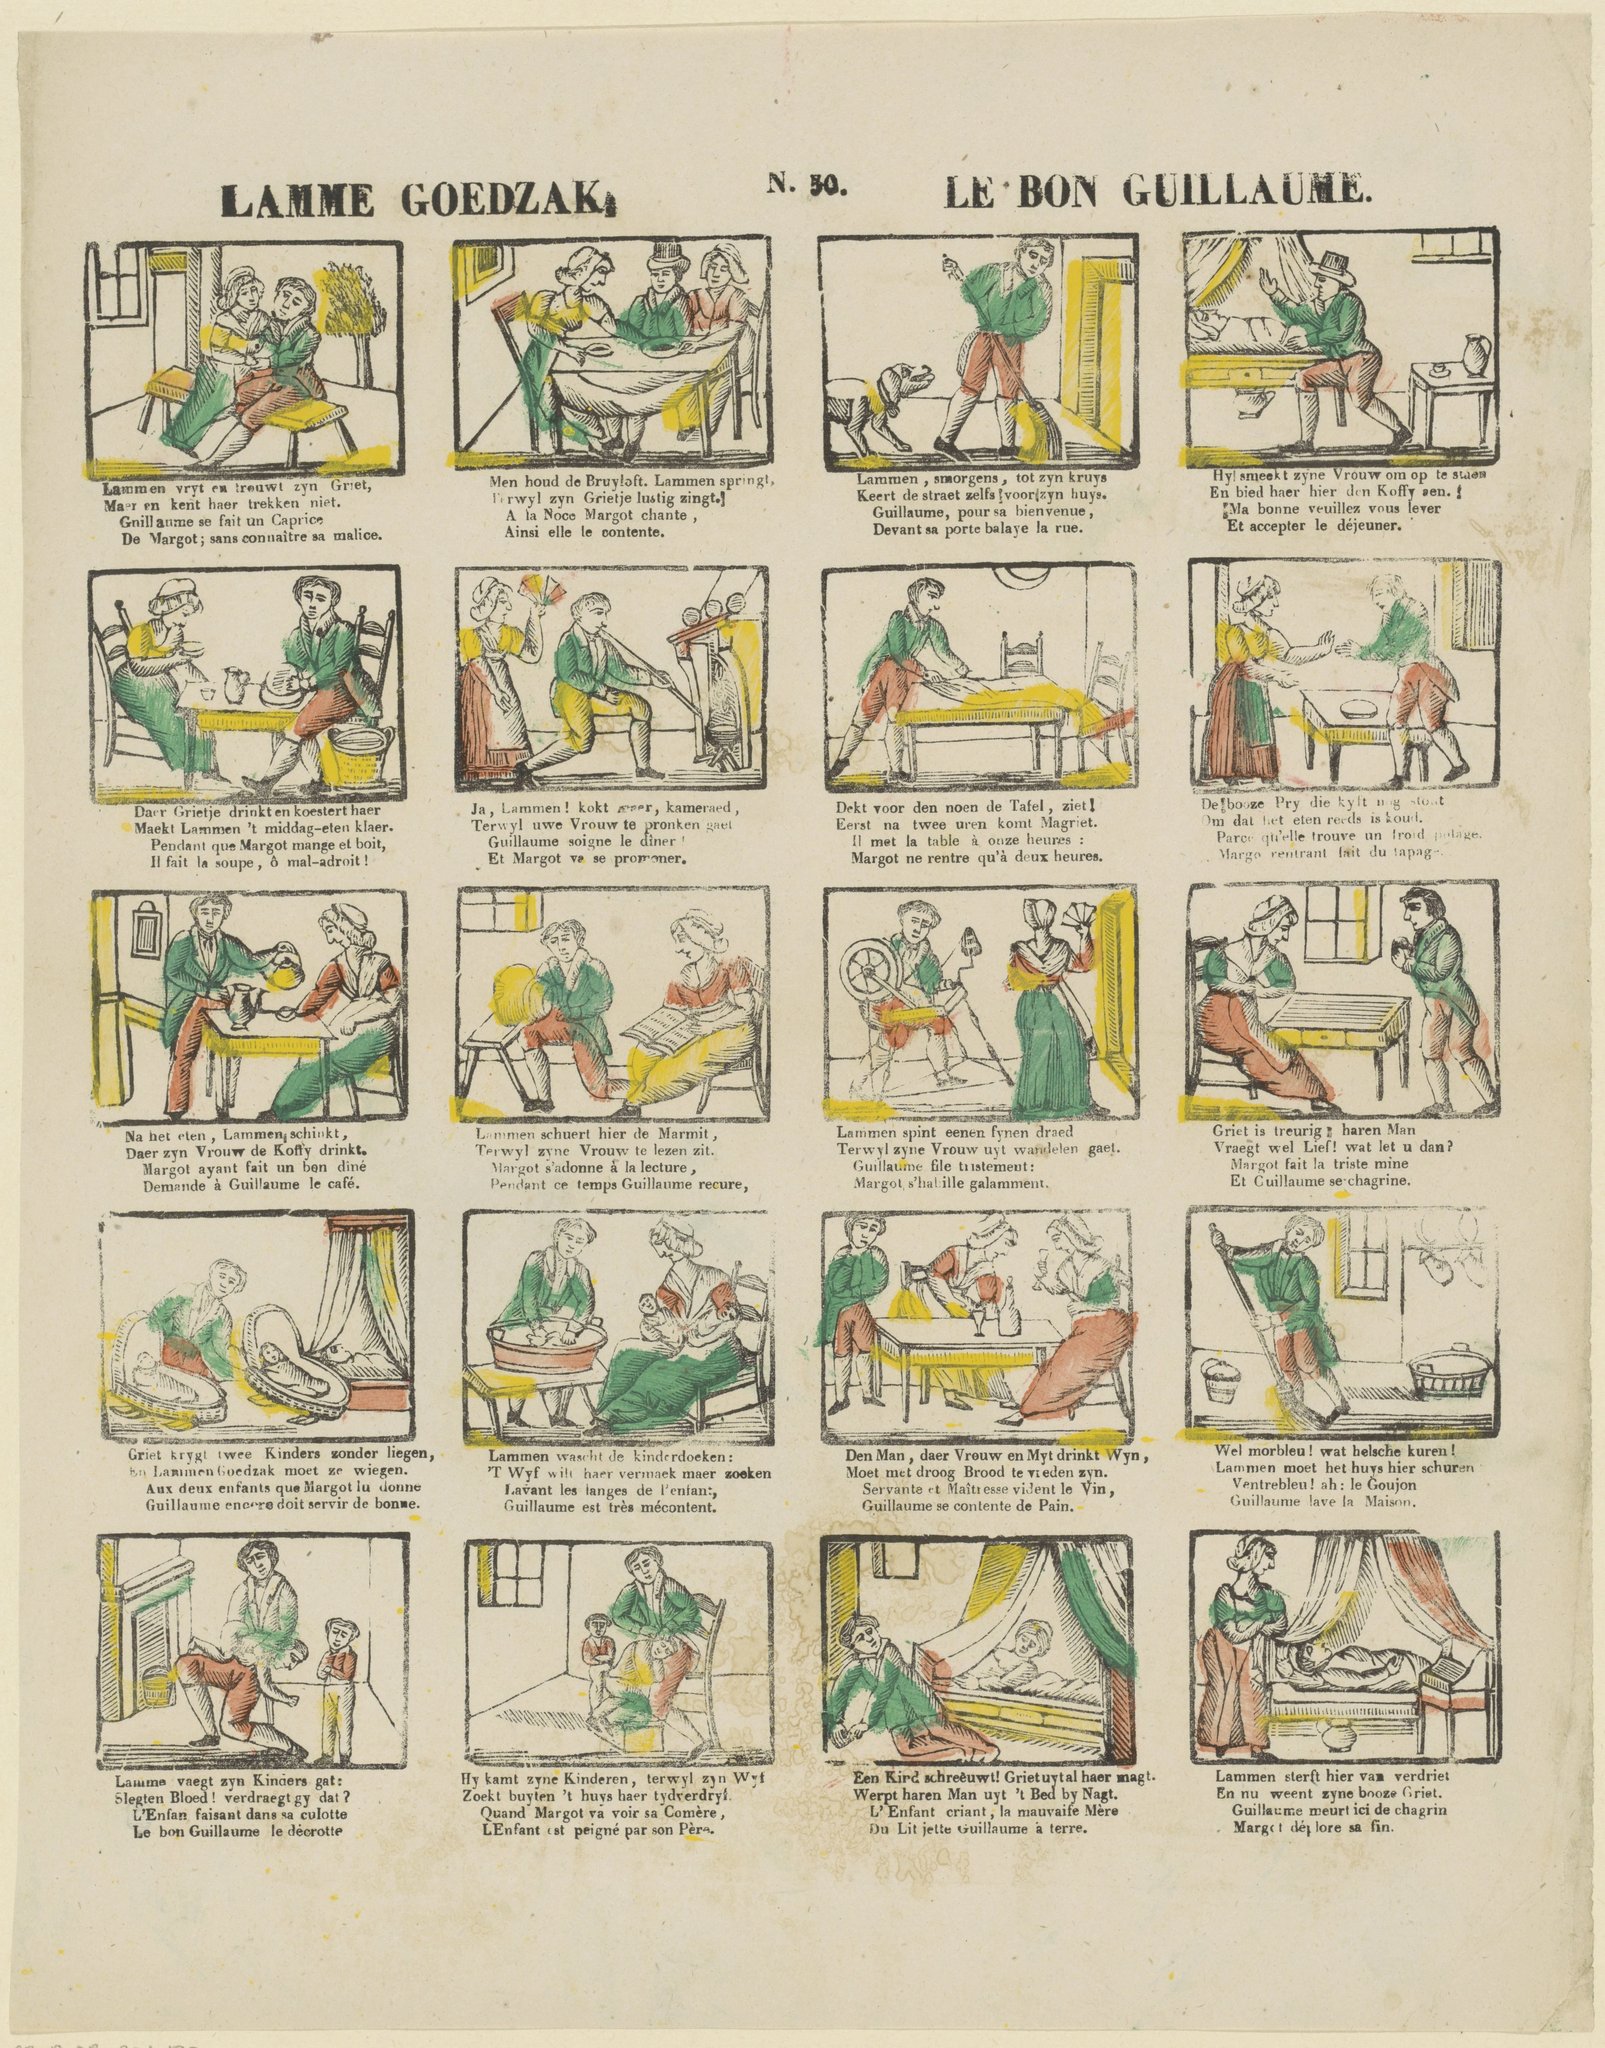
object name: print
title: Lamme goedzak / Le bon Guillaume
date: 1866-1902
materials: paper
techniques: colour, letterpress printing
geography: europe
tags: hen-pecked husband, 'betty', 'molly' (man who engages in women's work)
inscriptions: collector's mark: Lugt 2760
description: Blad met 20 voorstellingen over het leven en de bezigheden van Lamme Goedzak en zijn Griet. Onder elke voorstelling een tweeregelig vers in het Nederlands en het Frans. Genummerd midden boven: N. 50.